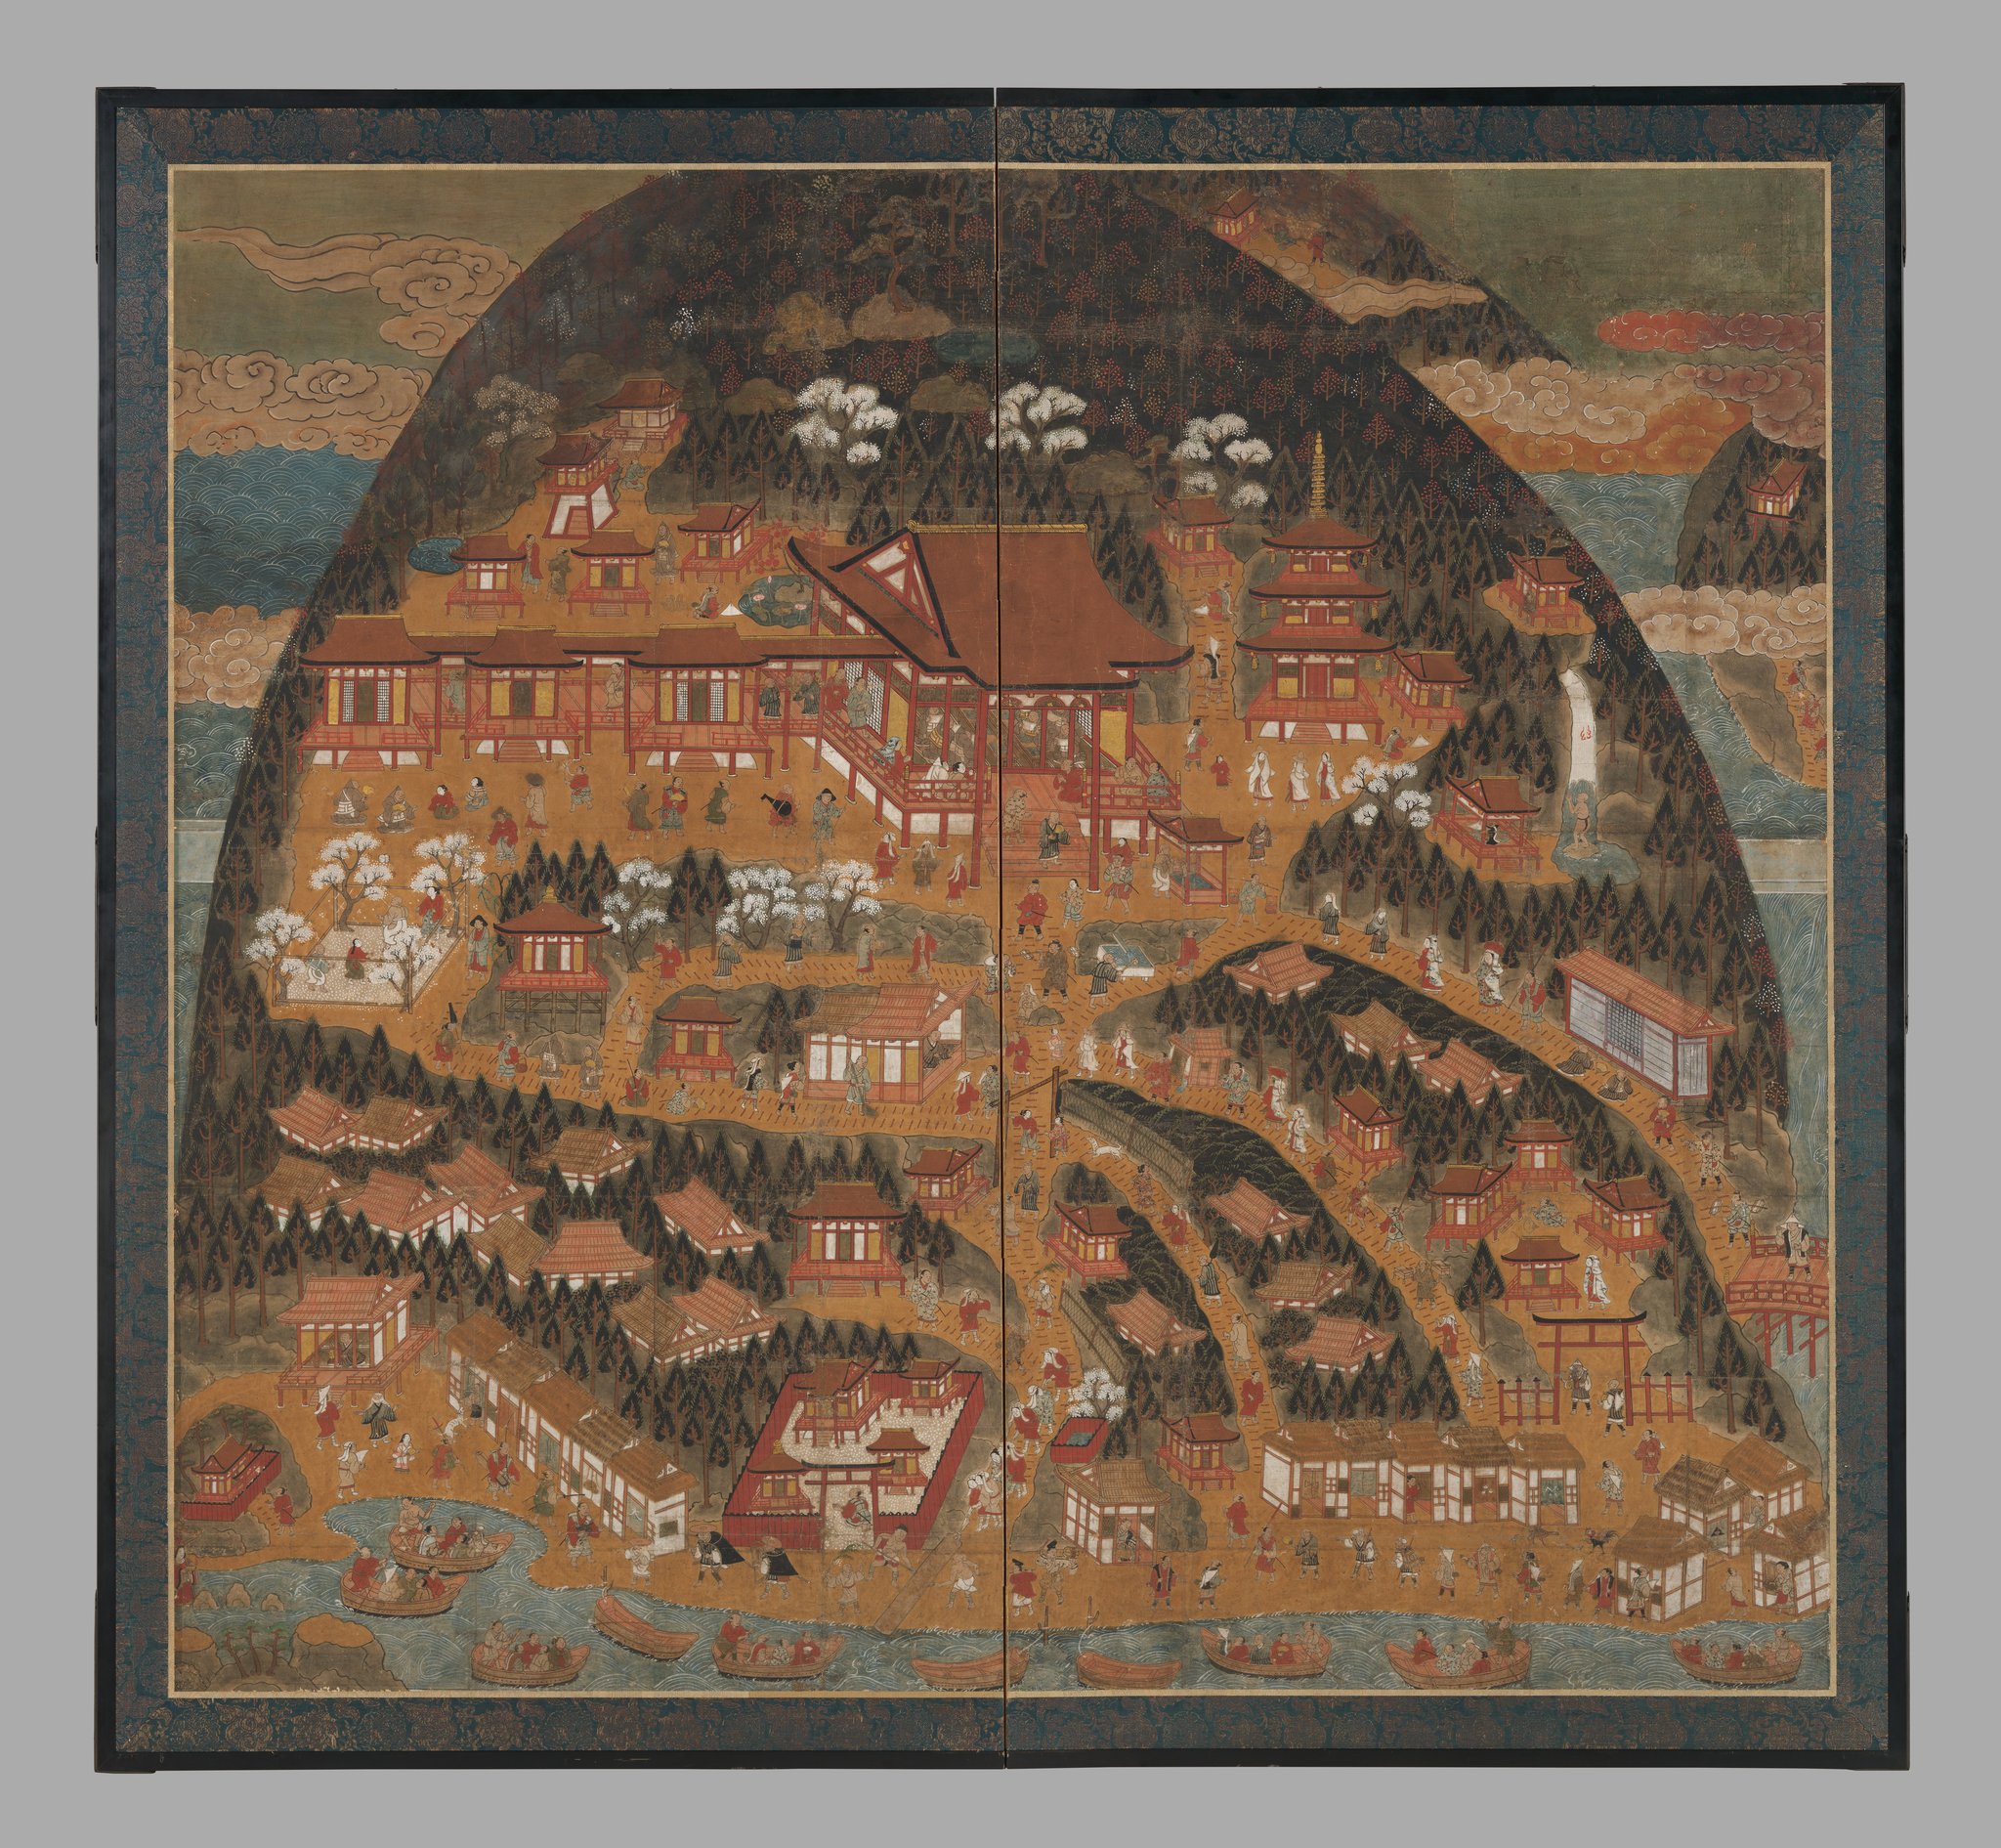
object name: screen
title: Chōmeiji Temple Pilgrimage Mandala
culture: japanese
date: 1526-1550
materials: gold, ink, panel, paper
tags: temples,men,boats